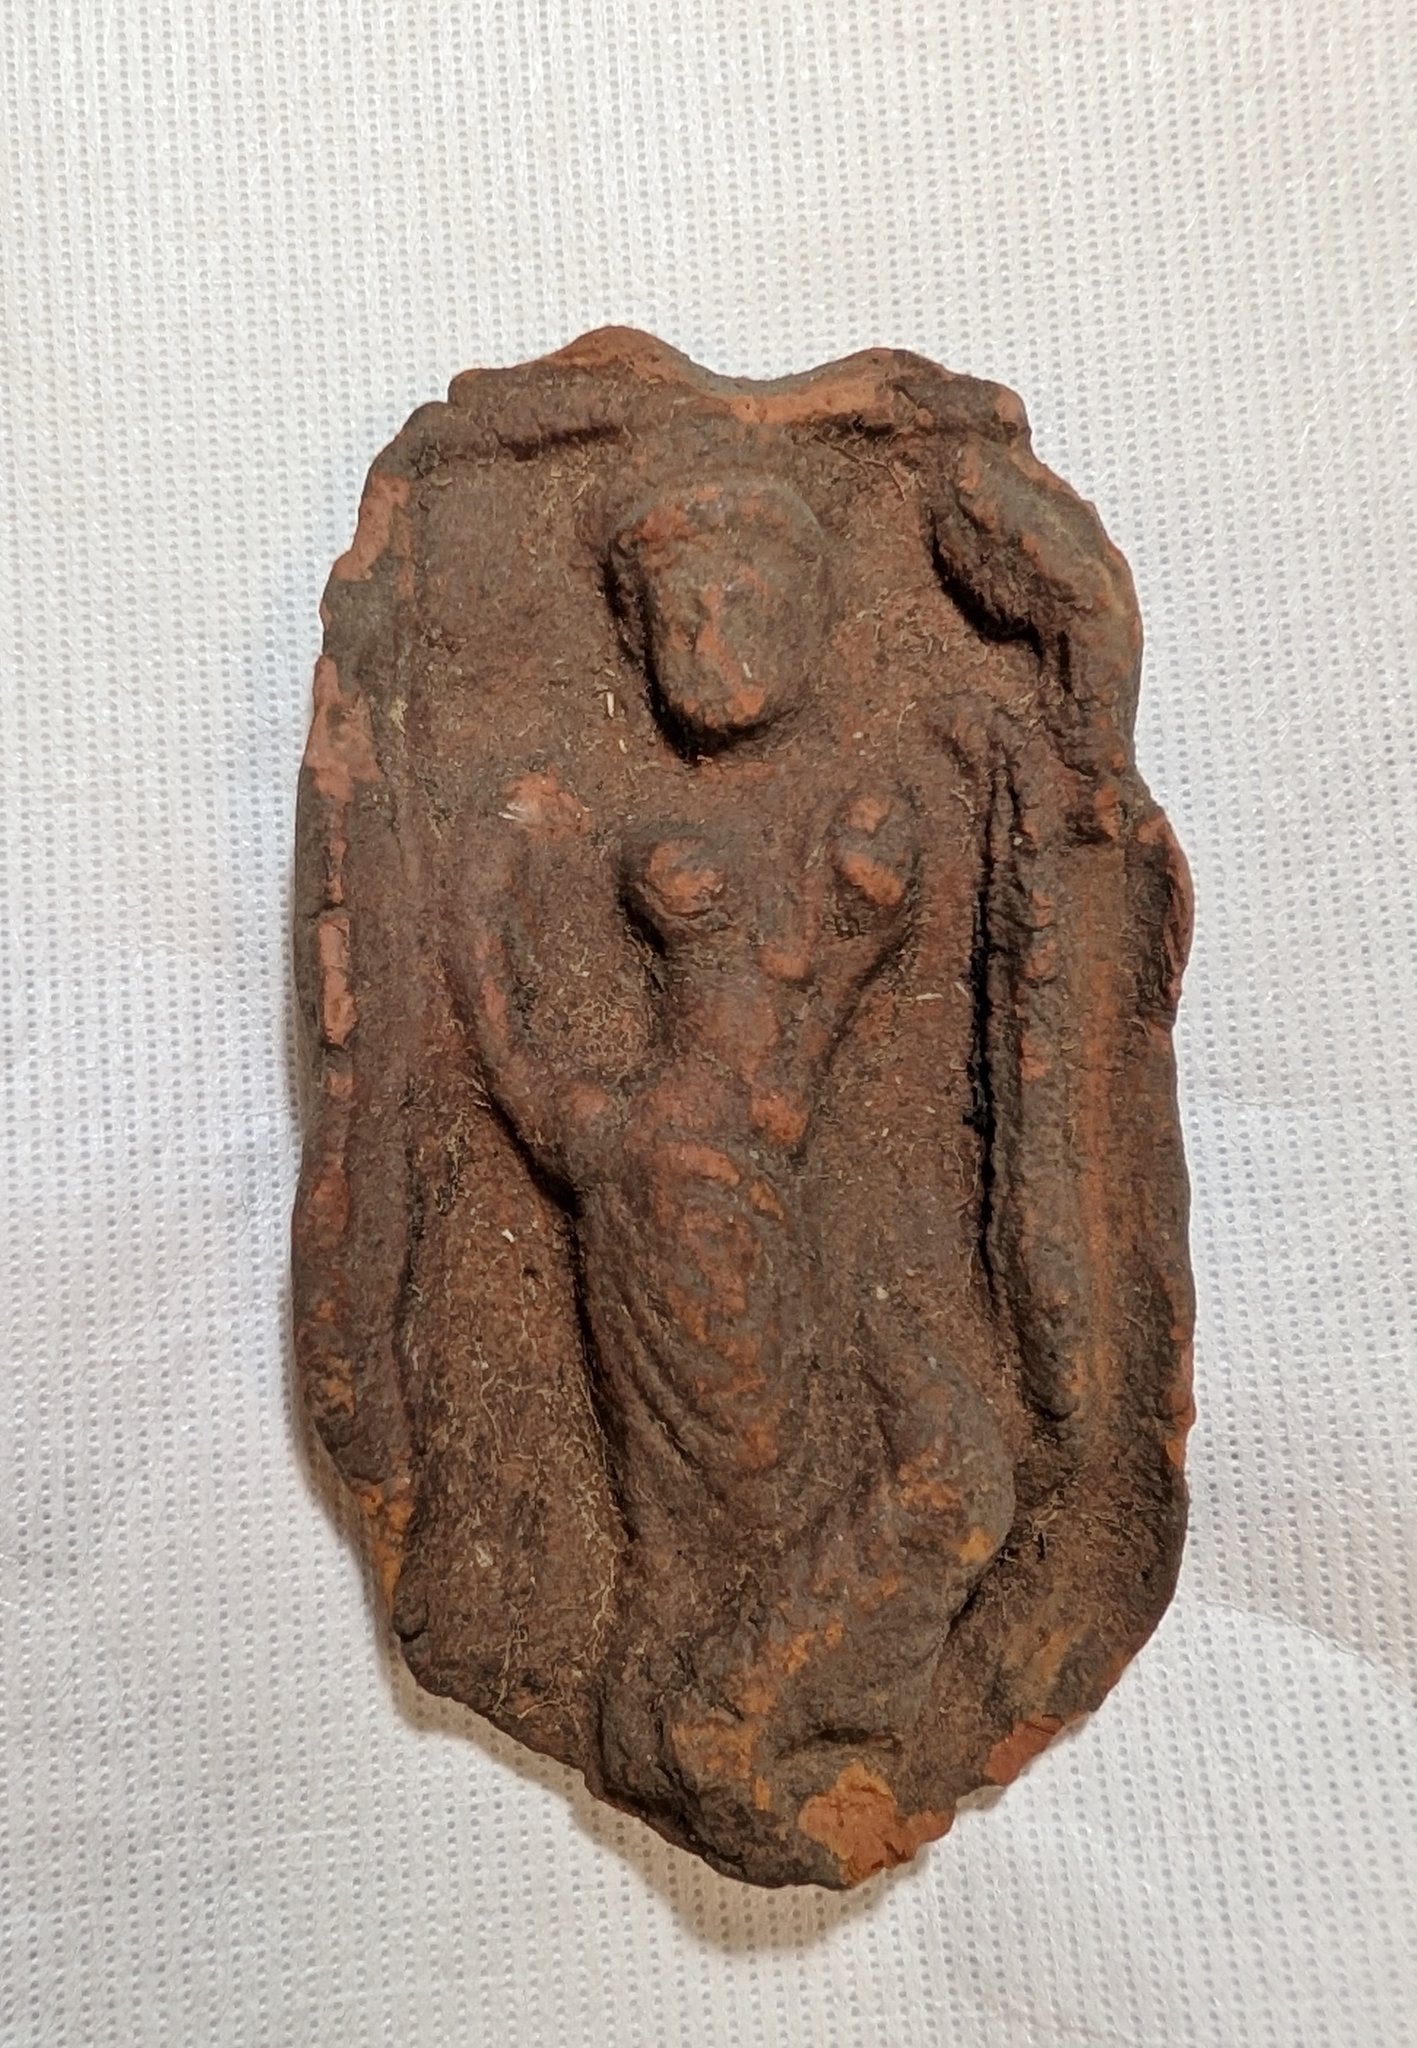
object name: plaque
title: Plaque in the Form of a Female Figure (Study Collection)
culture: pakistani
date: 101-300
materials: terracotta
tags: gandhara